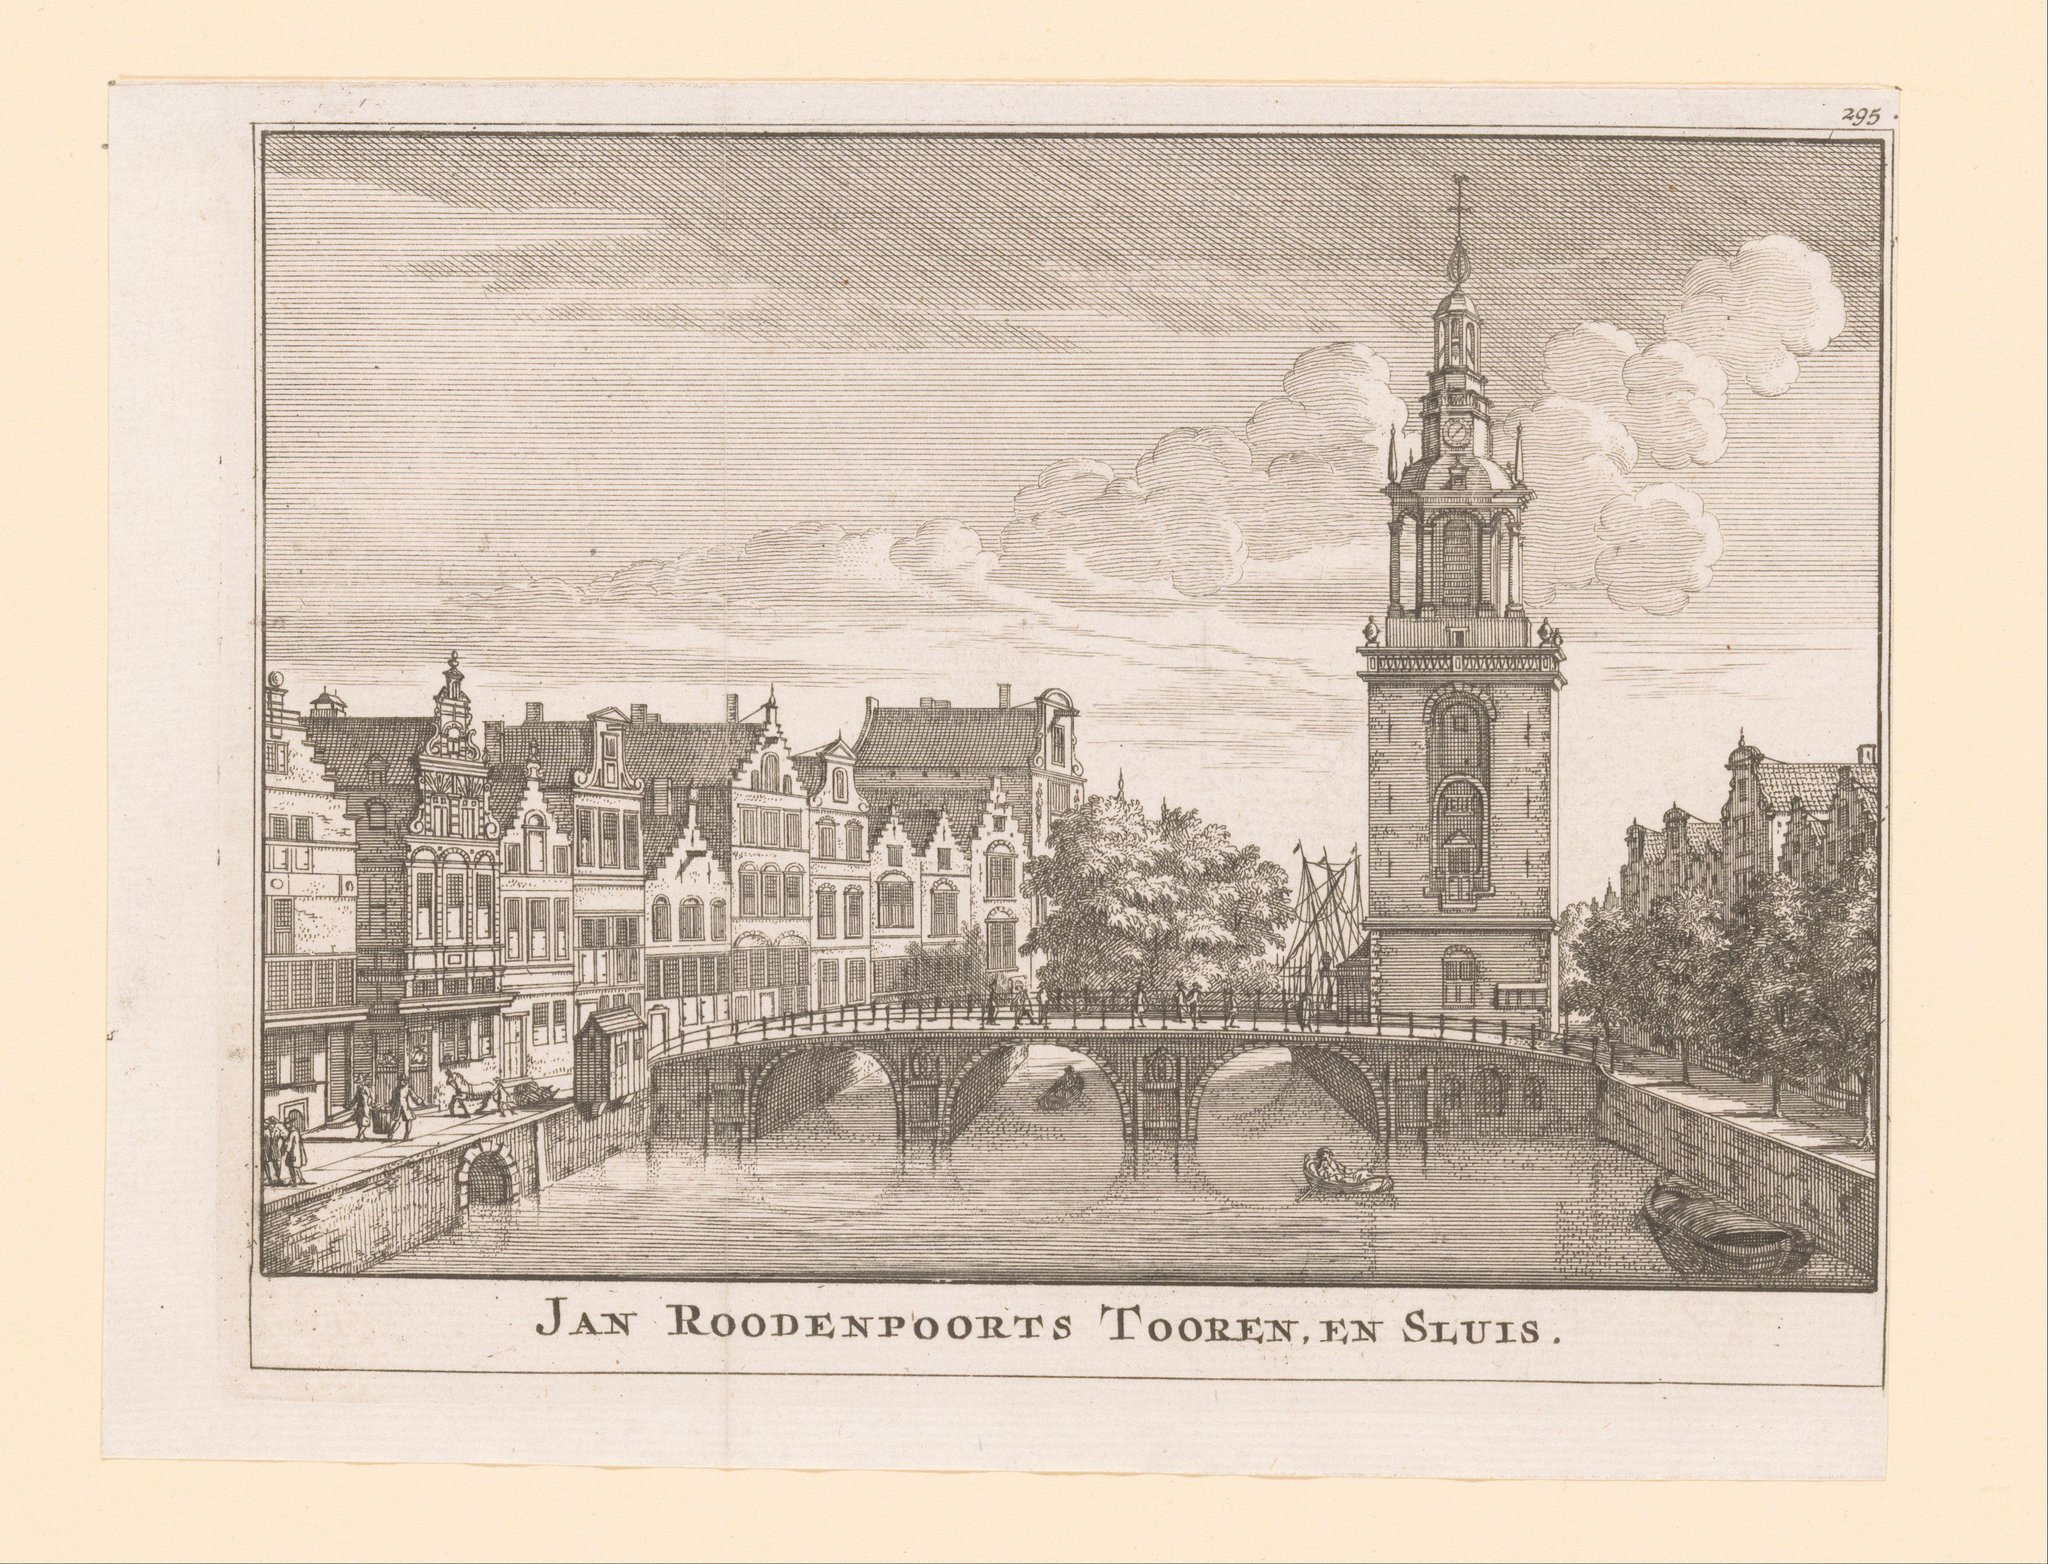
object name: book illustration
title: Gezicht op de Jan Roodenpoortstoren in Amsterdam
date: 1726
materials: paper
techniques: engraving, etching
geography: amsterdam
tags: tower, clock tower ~ monumental adornment, towers ~ fortified city, rowing-boat, canoe, etc., bridge in city across river, canal, etc.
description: Huidige staat van prent, genummerd 295, gebruikt in: Hoorn, Nicolaas ten. Wegwyzer door Amsterdam zynde eene beknopte verhandeling van desselfs eerste opkomst, vergrootingen, en teegenwoordigen staat (...). Amsterdam: Nicolaas ten Hoorn, 1726. En in: Hoorn, Nicolaas ten. Wegwyzer door Amsterdam zynde eene beknopte verhandeling van desselfs eerste opkomst, vergrootingen, en teegenwoordigen staat (...). Amsterdam: erven J. Ratelband & Co, 1737. En in: Hoorn, Nicolaas ten. Wegwyzer door Amsterdam zynde eene beknopte verhandeling van desselfs eerste opkomst, vergrootingen, en teegenwoordigen staat (...). Amsterdam: Pieter Meyer, 1751. Eerste staat van prent, genummerd 277, gebruikt in: Hoorn, Nicolaas ten. Wegwyzer door Amsterdam zynde eene beknopte verhandeling van desselfs eerste opkomst, vergrootingen, en teegenwoordigen staat (...). Amsterdam: Nicolaas ten Hoorn, 1713. En in: Hoorn, Nicolaas ten. Wegwyzer door Amsterdam zynde eene beknopte verhandeling van desselfs eerste opkomst, vergrootingen, en teegenwoordigen staat (...). Amsterdam: Nicolaas ten Hoorn, 1726. Derde staat van prent ongenummerd, zie KOG-AA-1-29-40.